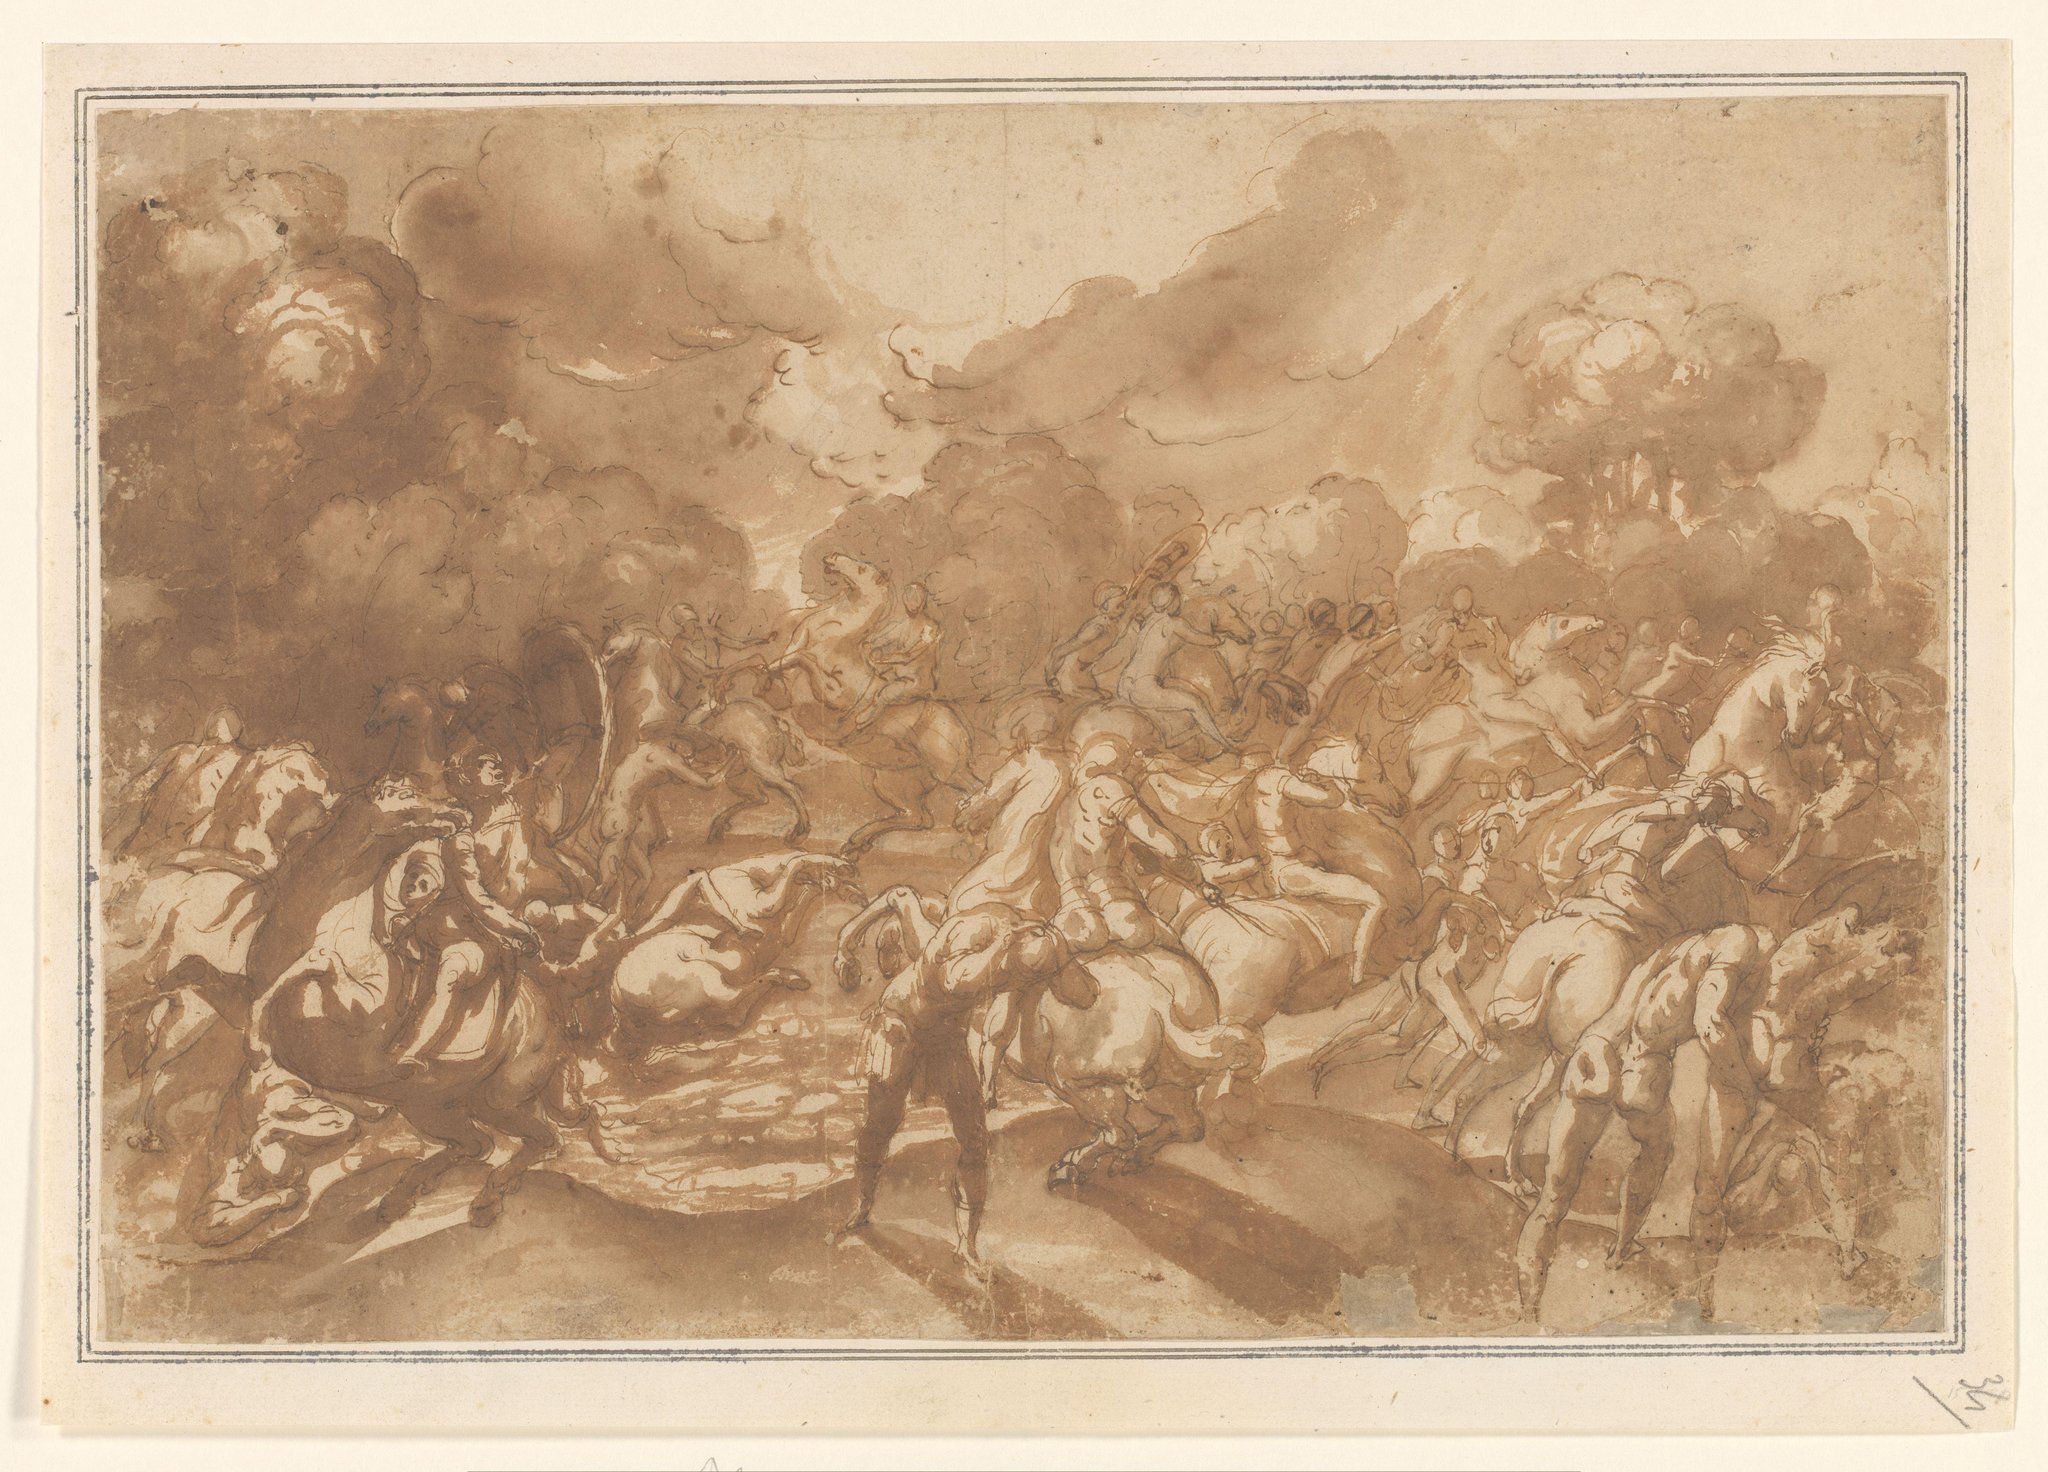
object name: drawing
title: De bekering van Paulus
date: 1587-1640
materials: ink, paper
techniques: brush, pen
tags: on the way to damascus christ appears to saul, who falls from his horse and is blinded by the light